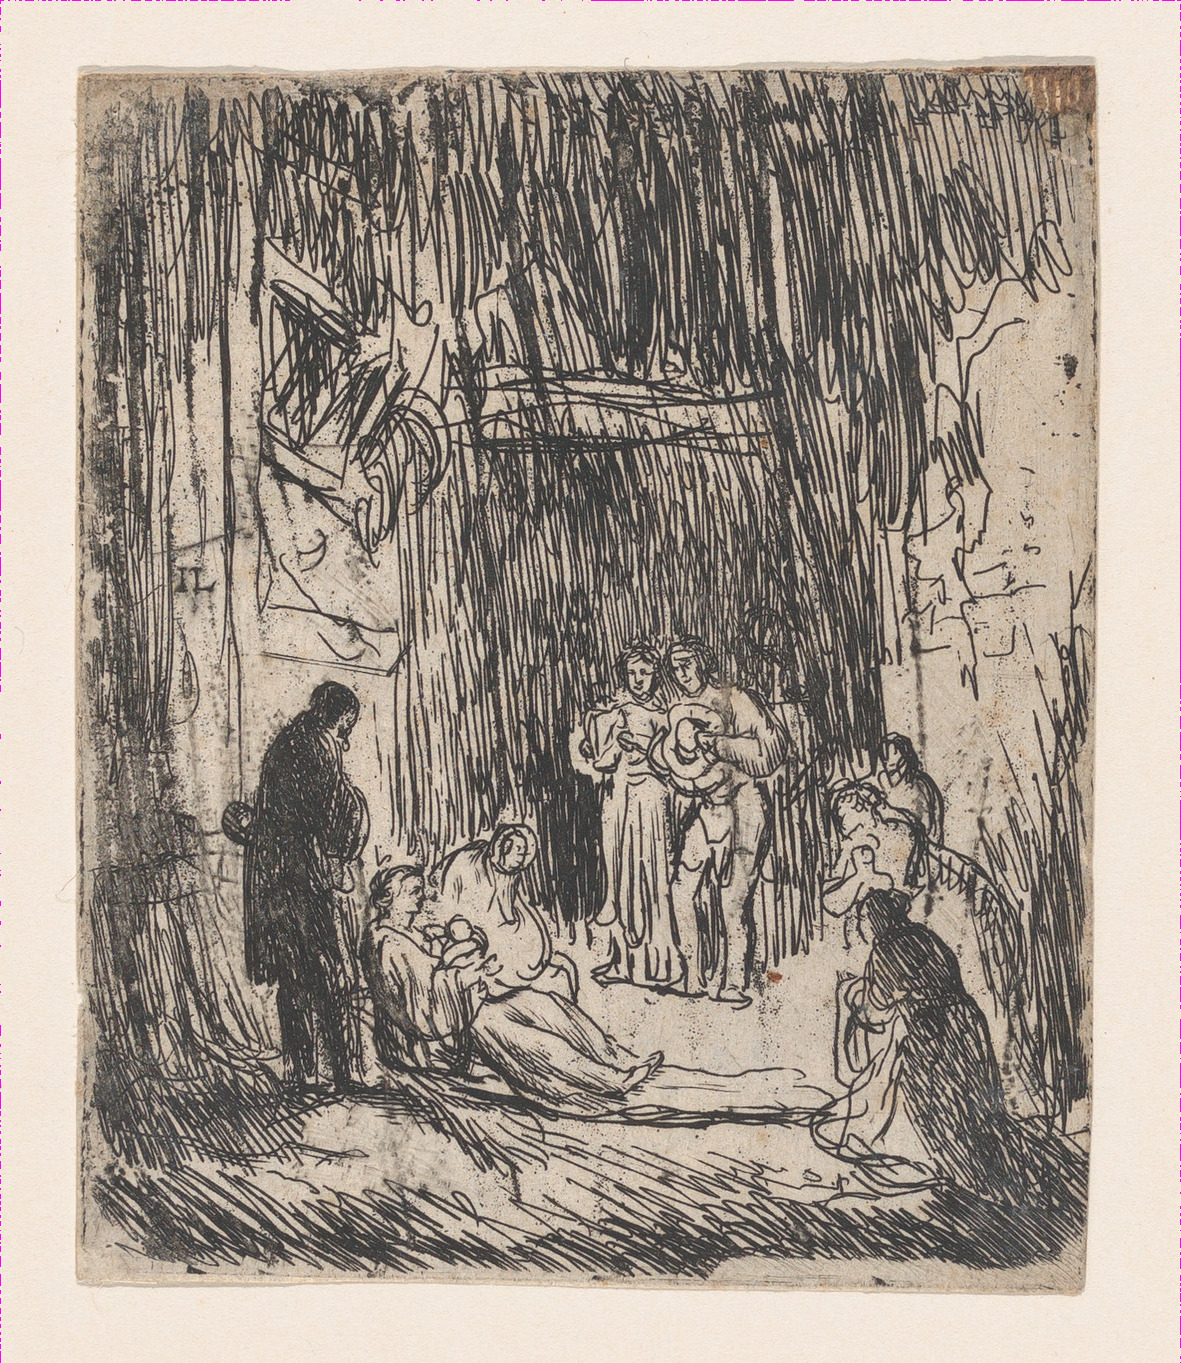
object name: print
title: Adoration of the Shepherds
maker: jan lievens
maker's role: artist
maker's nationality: dutch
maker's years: 1607-1674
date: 1601-1700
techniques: etching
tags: adoration of the shepherds